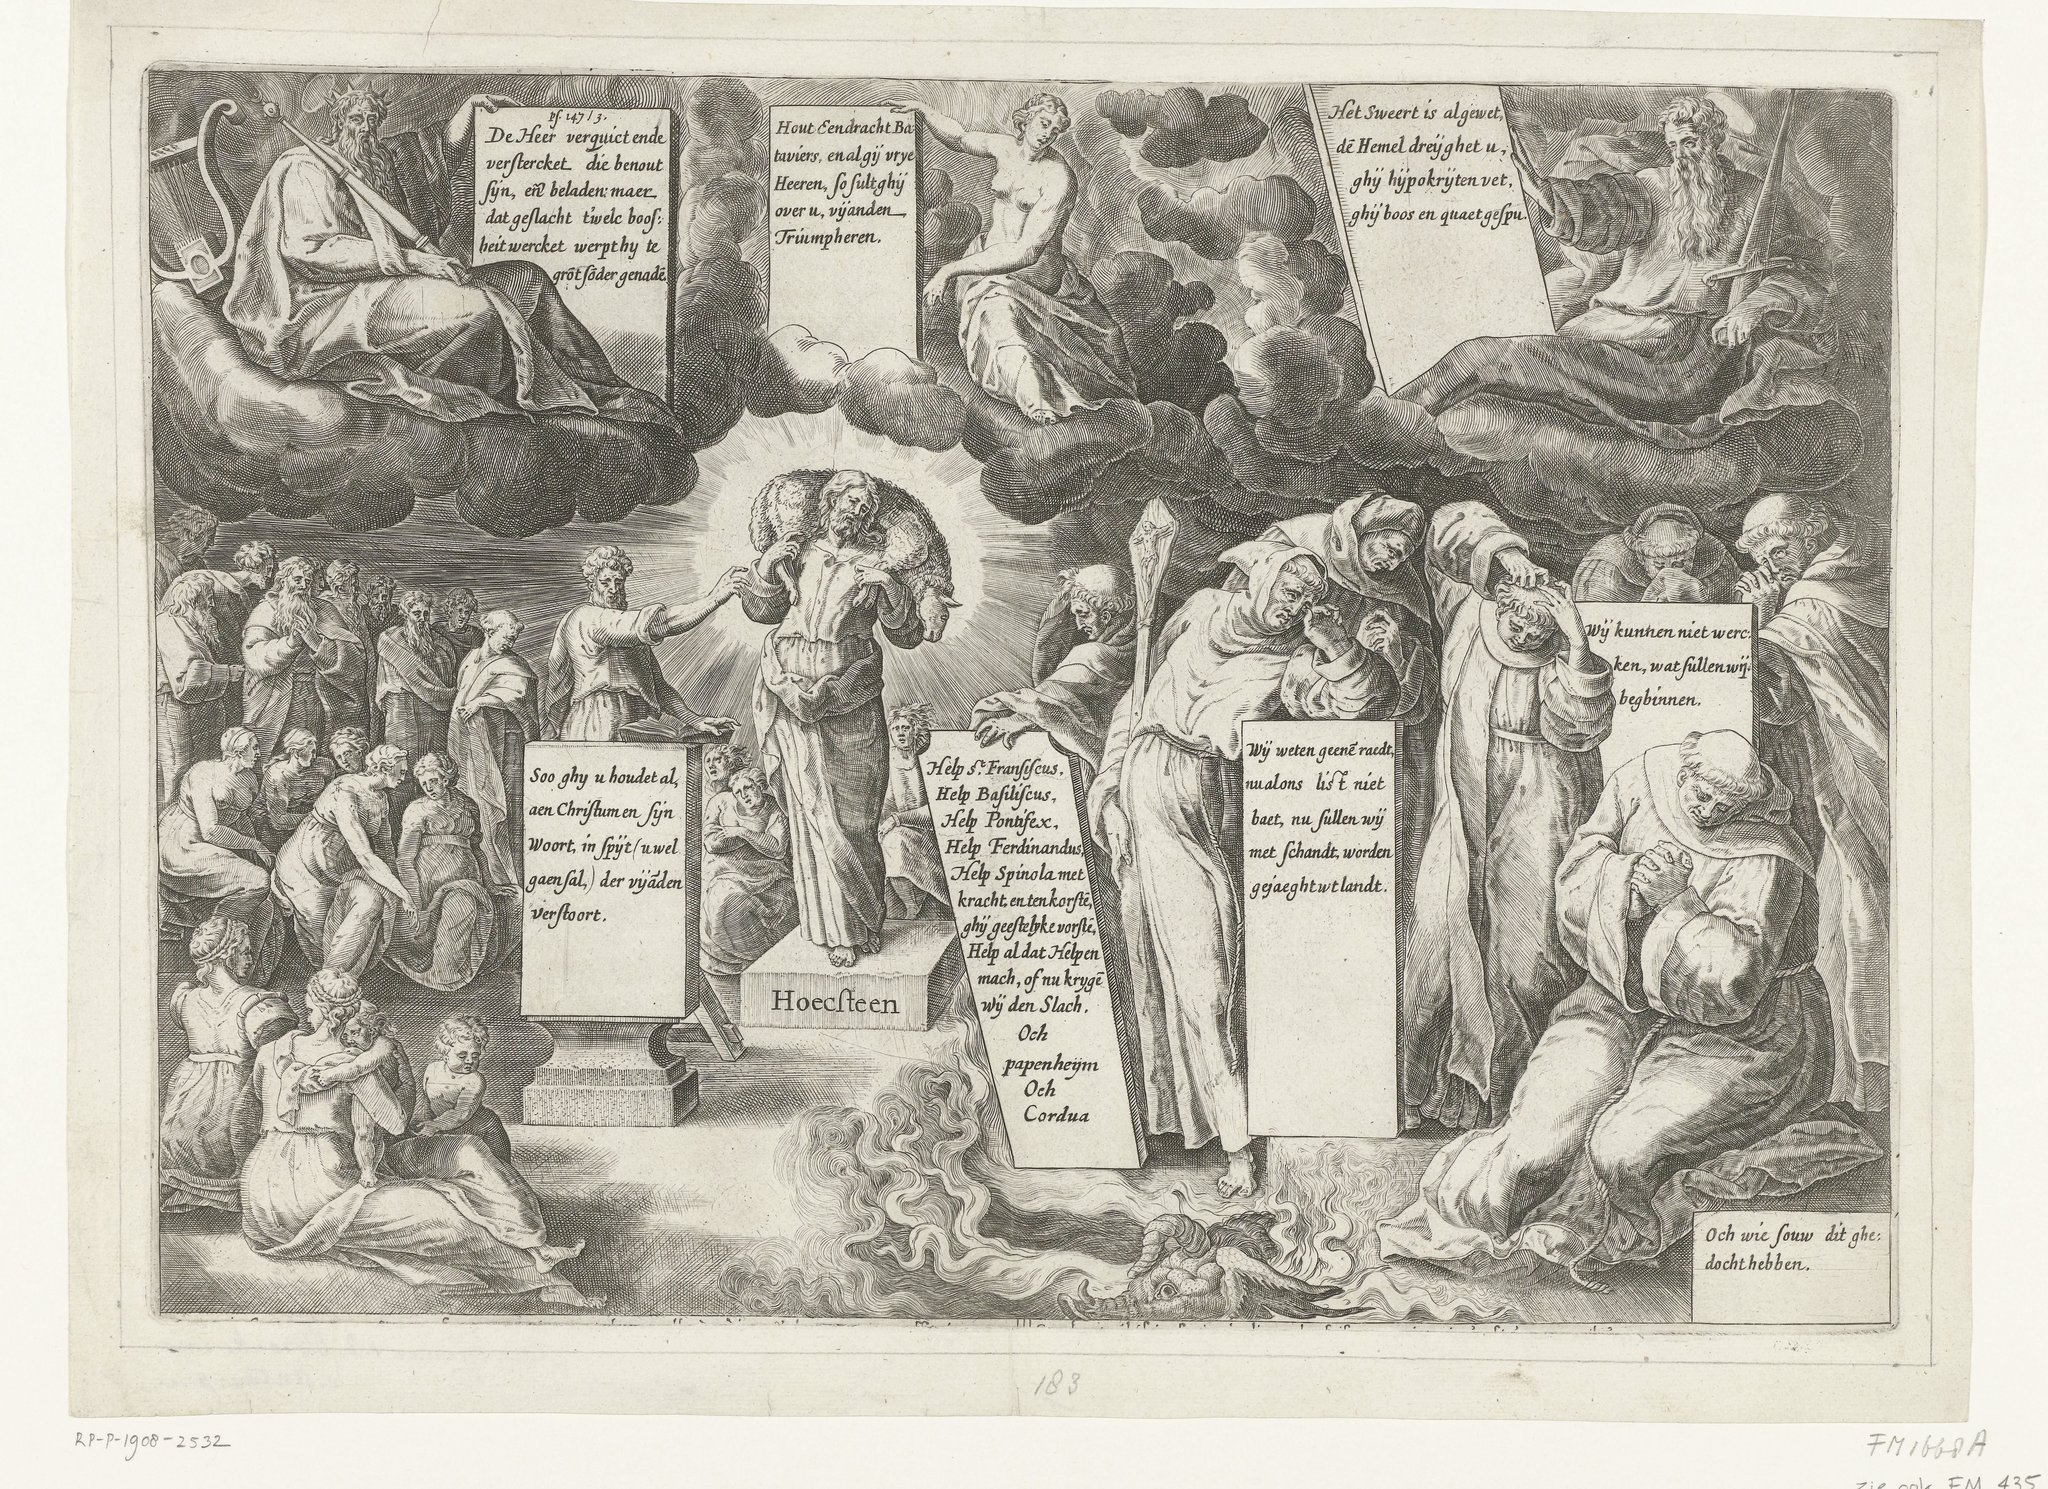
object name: cartoon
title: Spotprent op de katholieken na hun verliezen in 1627 en 1629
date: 1550-1590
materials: paper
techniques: engraving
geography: northern netherlands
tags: the lost sheep sought and found by the shepherd ~ parable of the good shepherd (matthew 18:12-14; luke 15:4-7), (aspects of) christian religion or the church (as institution) ridiculed, criticized, or caricaturized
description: Spotprent op de katholieken na hun verliezen in 1627 en 1629. Opschriften verwijzen naar Spinola, Ferdinand, Pappenheim en Cordua. Christus draagt het lam op zijn schouders als de goede herder, staande op de hoeksteen. Bij hem een predikant en het volk. Rechts treurende katholieke priesters en monniken. Aan hun voeten het hellevuur en de kop van de duivel. In de hemel koning David een vrouwelijke personificatie en Paulus. Met tekstborden met verschillende bijbelcitaten en andere opschriften. Een oudere originele plaat uit de tweede helft van de zestiende eeuw afgesneden en bewerkt.